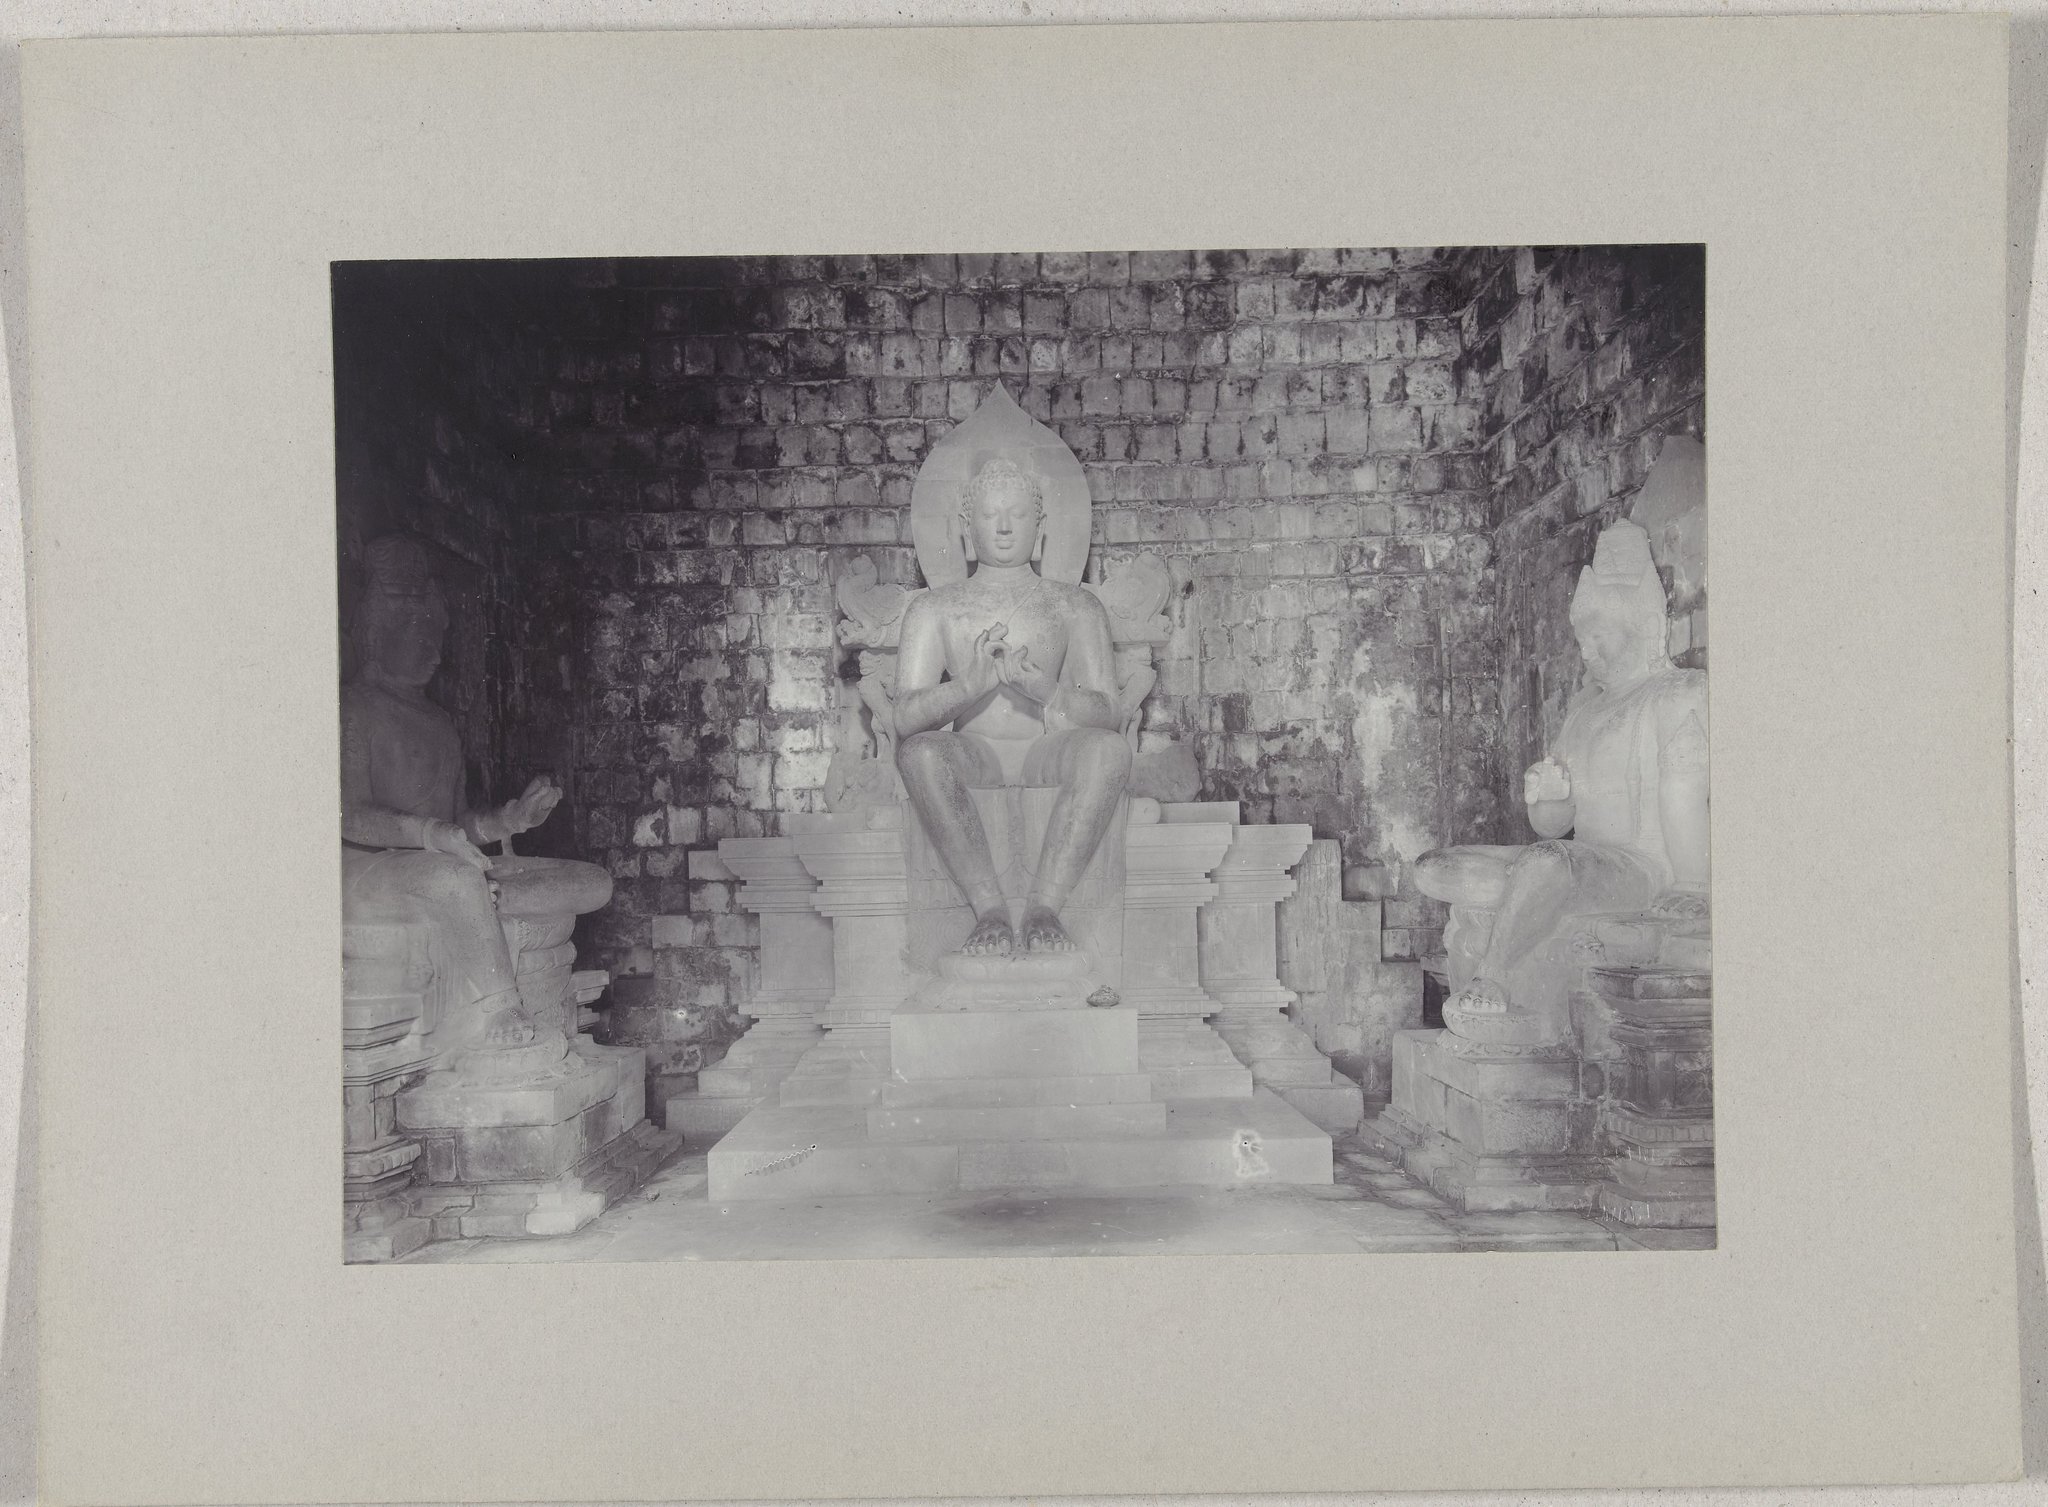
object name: photograph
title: 73. Mendoet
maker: otto hisgen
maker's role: fotograaf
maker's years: 1874-1944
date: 1895-1915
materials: cardboard, paper, photographic support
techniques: gelatin silver print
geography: magelang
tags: candi mendut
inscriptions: check stamp: ‘O. Hisgen & Co / Semarang’, annotation: ‘73. Mendoet’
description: Beelden van Boeddha en twee koningszonen in de Tempel Mendoet ten zuiden van Magelang, Nederlands-Indië